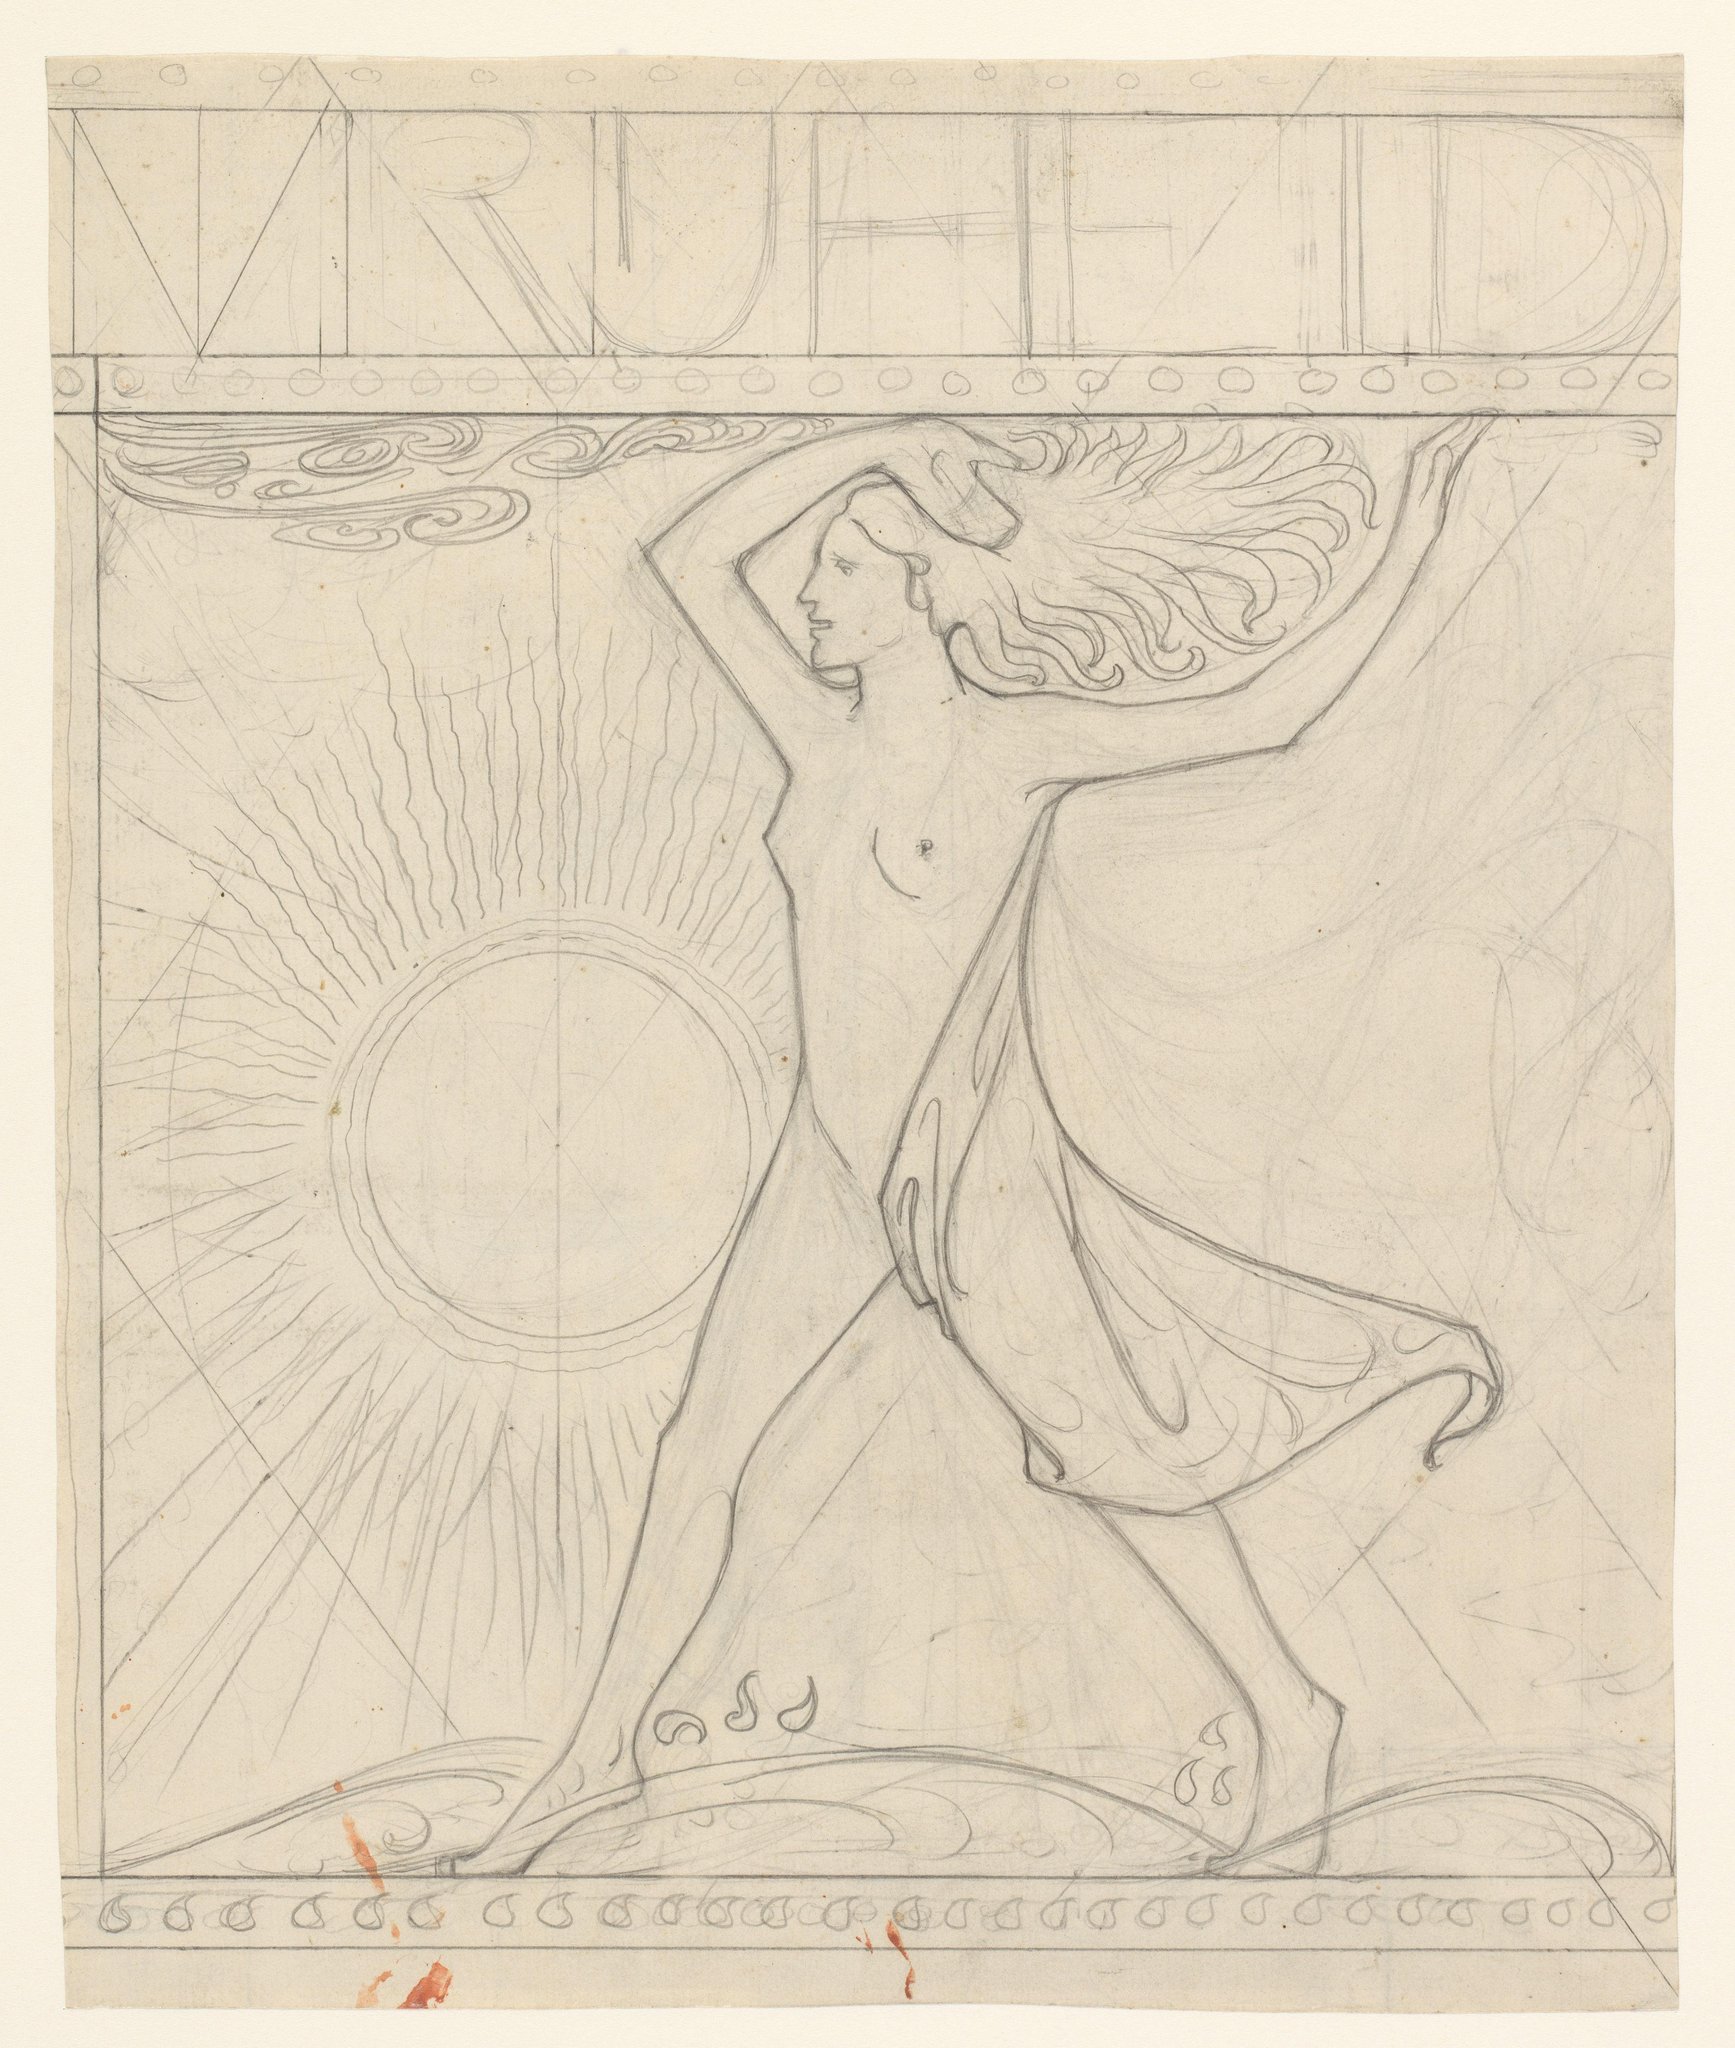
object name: design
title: Ontwerp voor schildering Algemene Nederlandsche Diamantbewerkersbond: Vrijheid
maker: richard nicolaüs roland holst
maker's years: 1868-1938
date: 1878-1938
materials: paper, pencil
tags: freedom, liberty; 'libertà' (ripa) (+ abstract concept represented by female figure)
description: Naakte vrouw en zon, ontwerp voor een schildering.